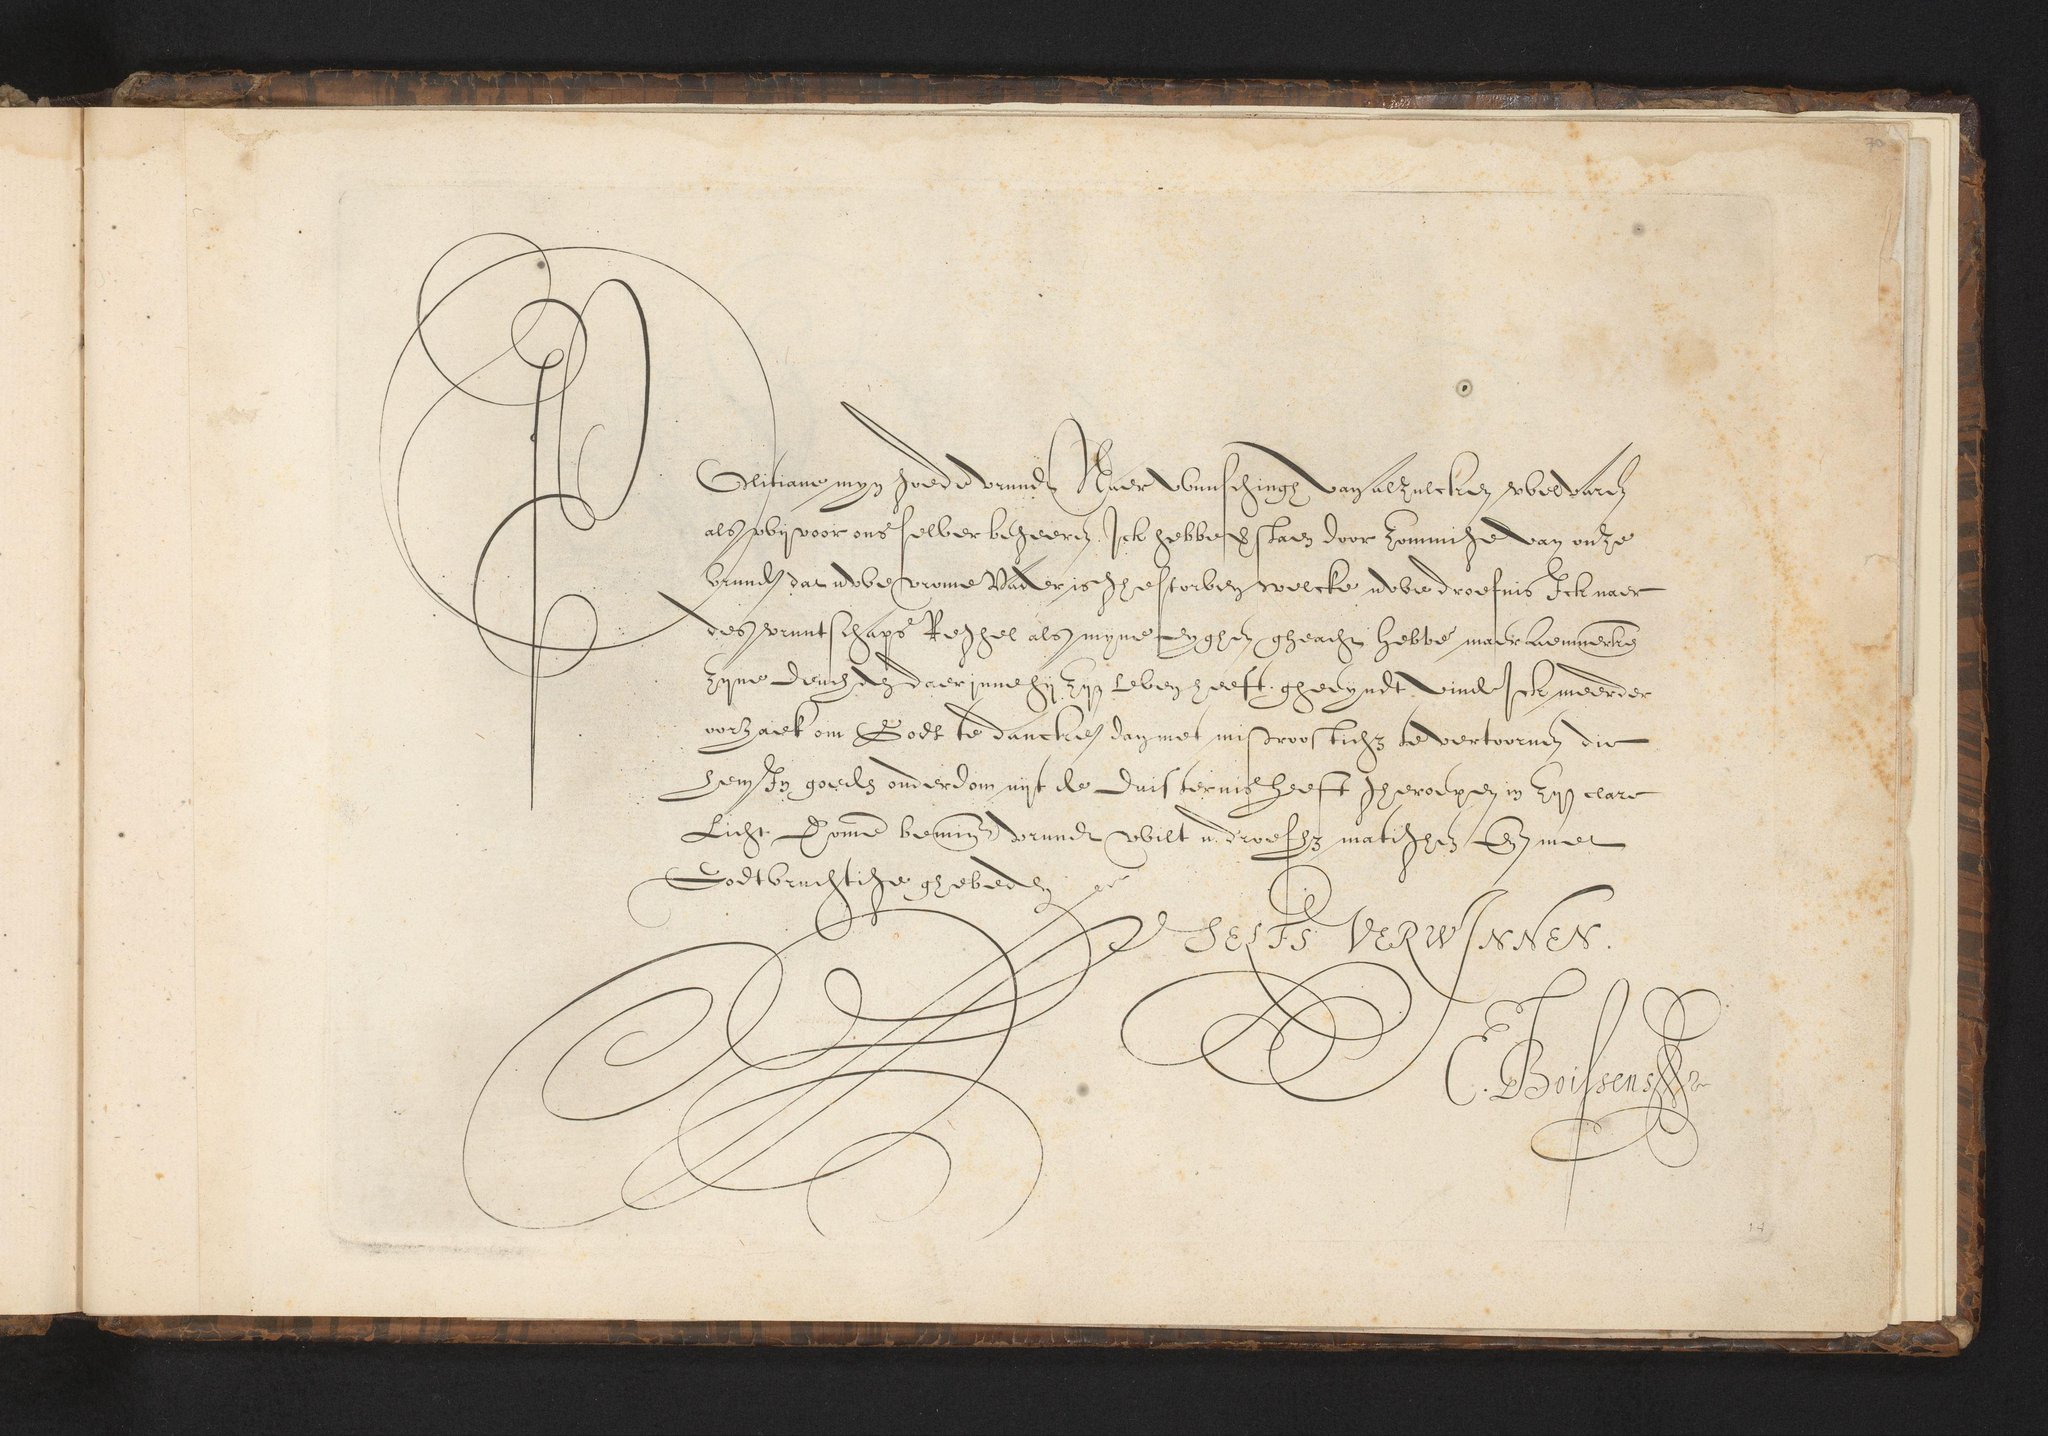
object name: ornament print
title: Schrijfvoorbeeld: Politiane myn goede (...)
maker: cornelis dircksz. boissens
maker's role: draughtsman, print maker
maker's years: 1567-1635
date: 1605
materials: paper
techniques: engraving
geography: amsterdam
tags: calligraphy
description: Schrijfvoorbeeld met negen regels tekst in het Nederlands: Politiane myn goede ... De prent maakt deel uit van een album.